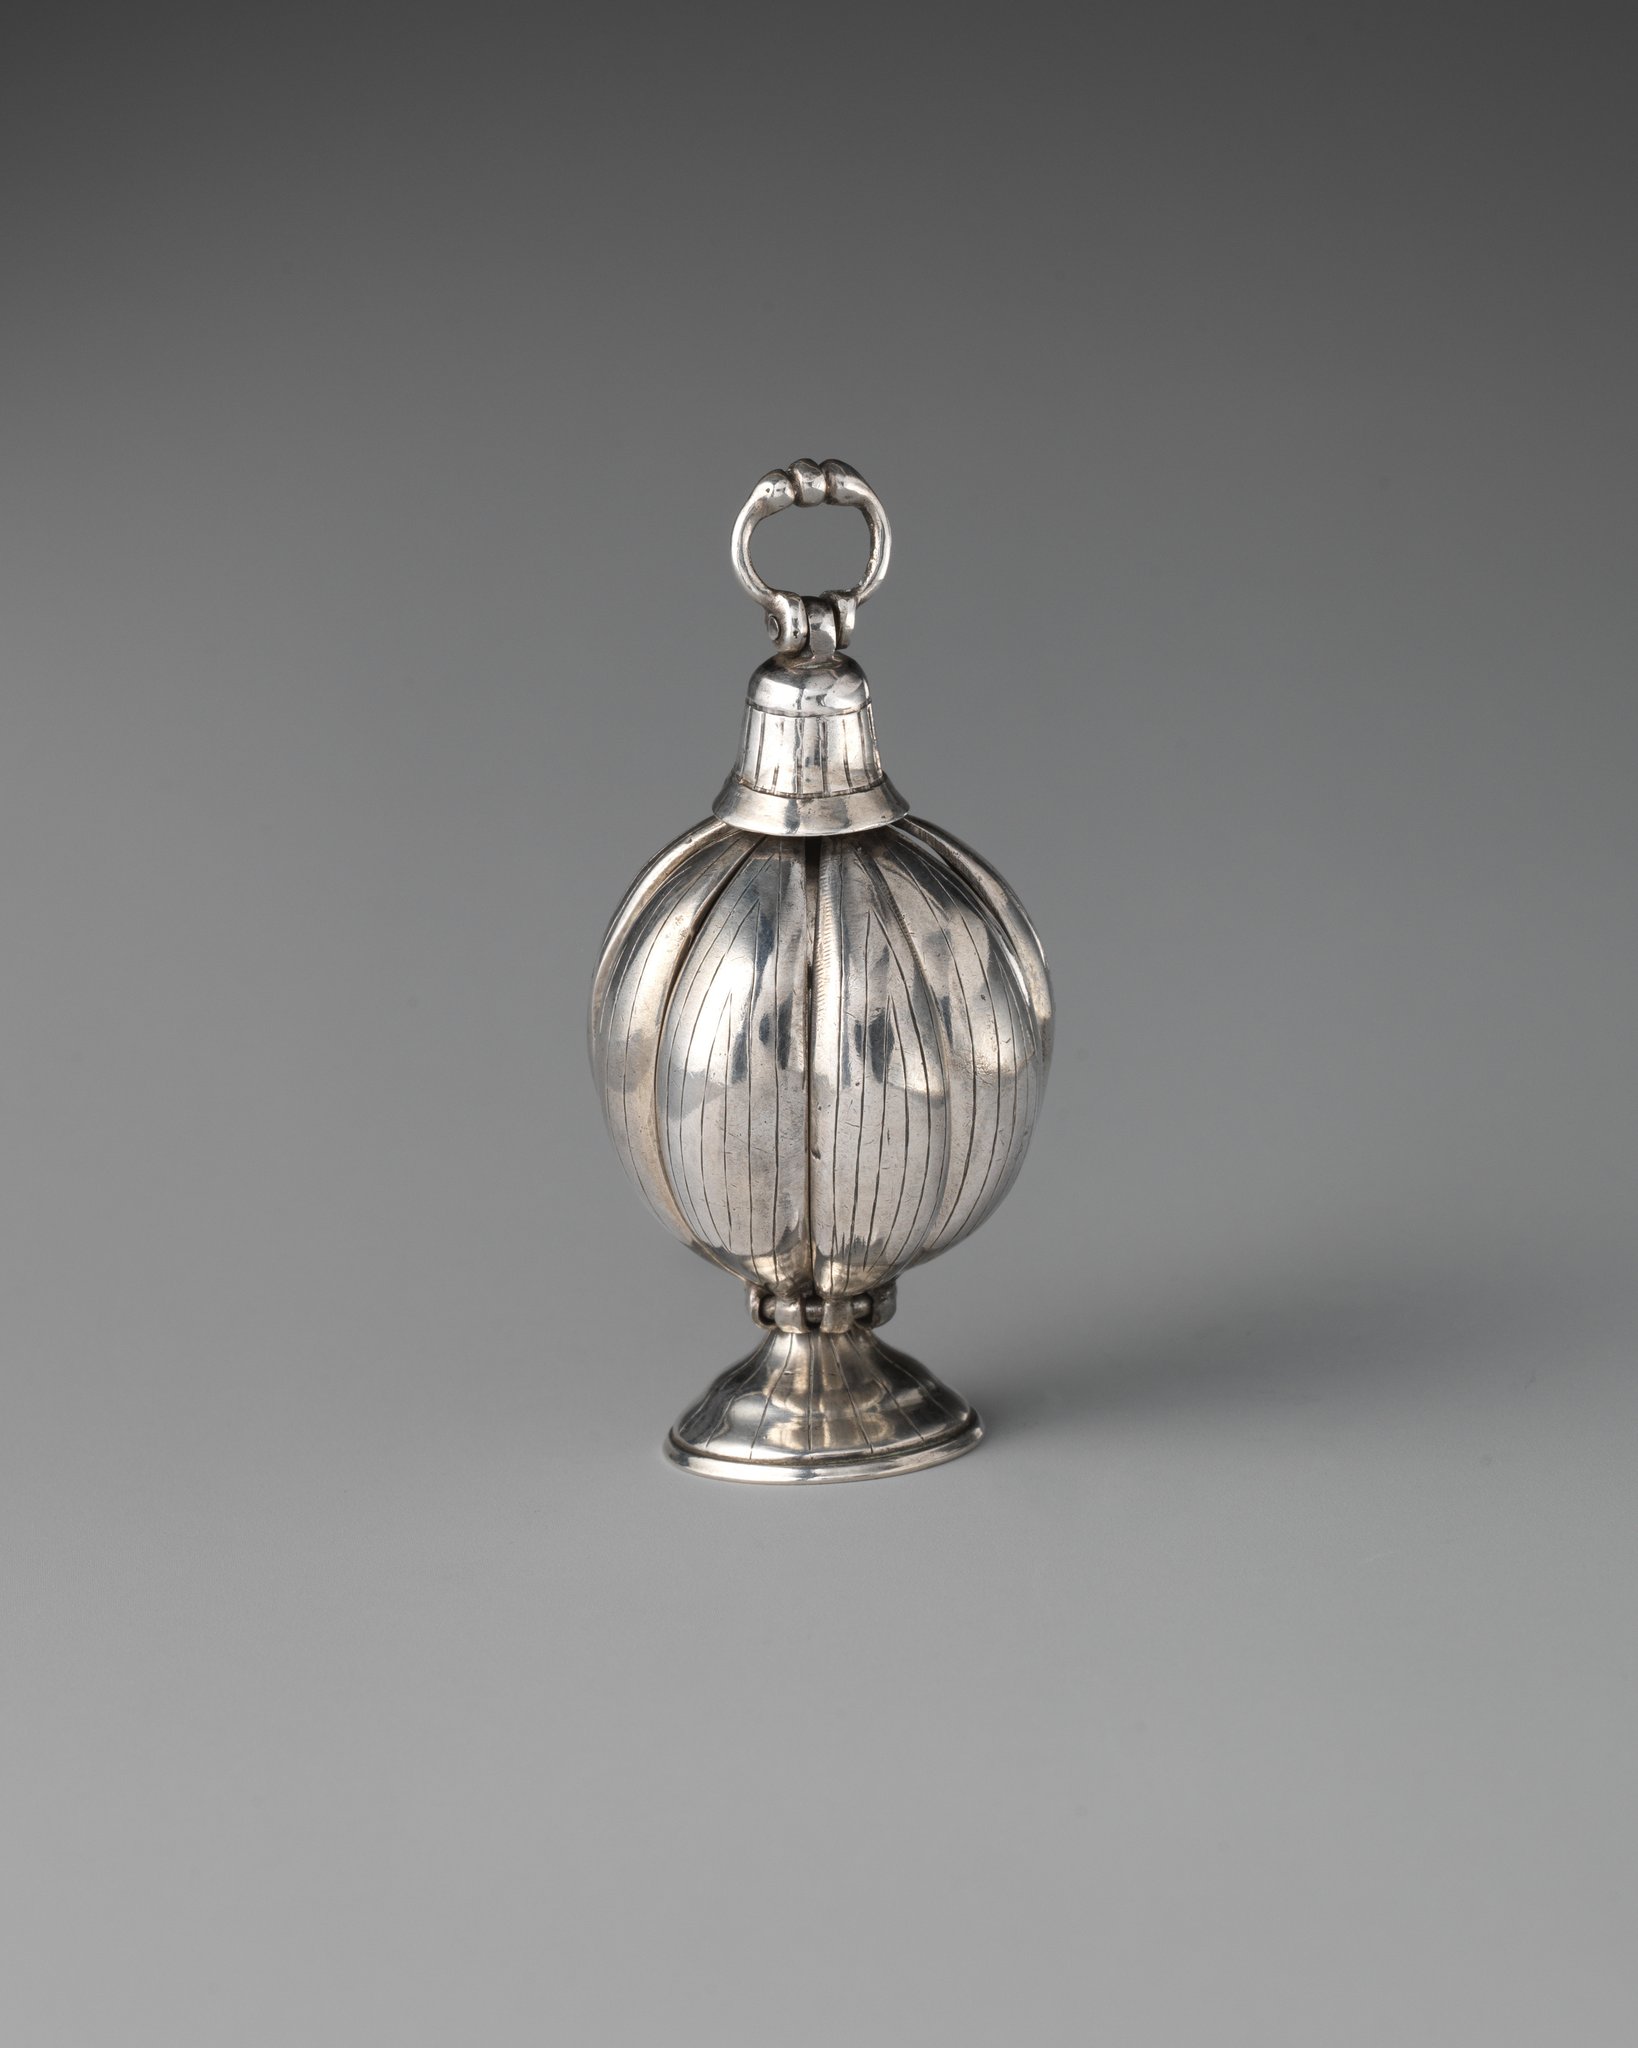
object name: pomander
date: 1601-1700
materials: silver